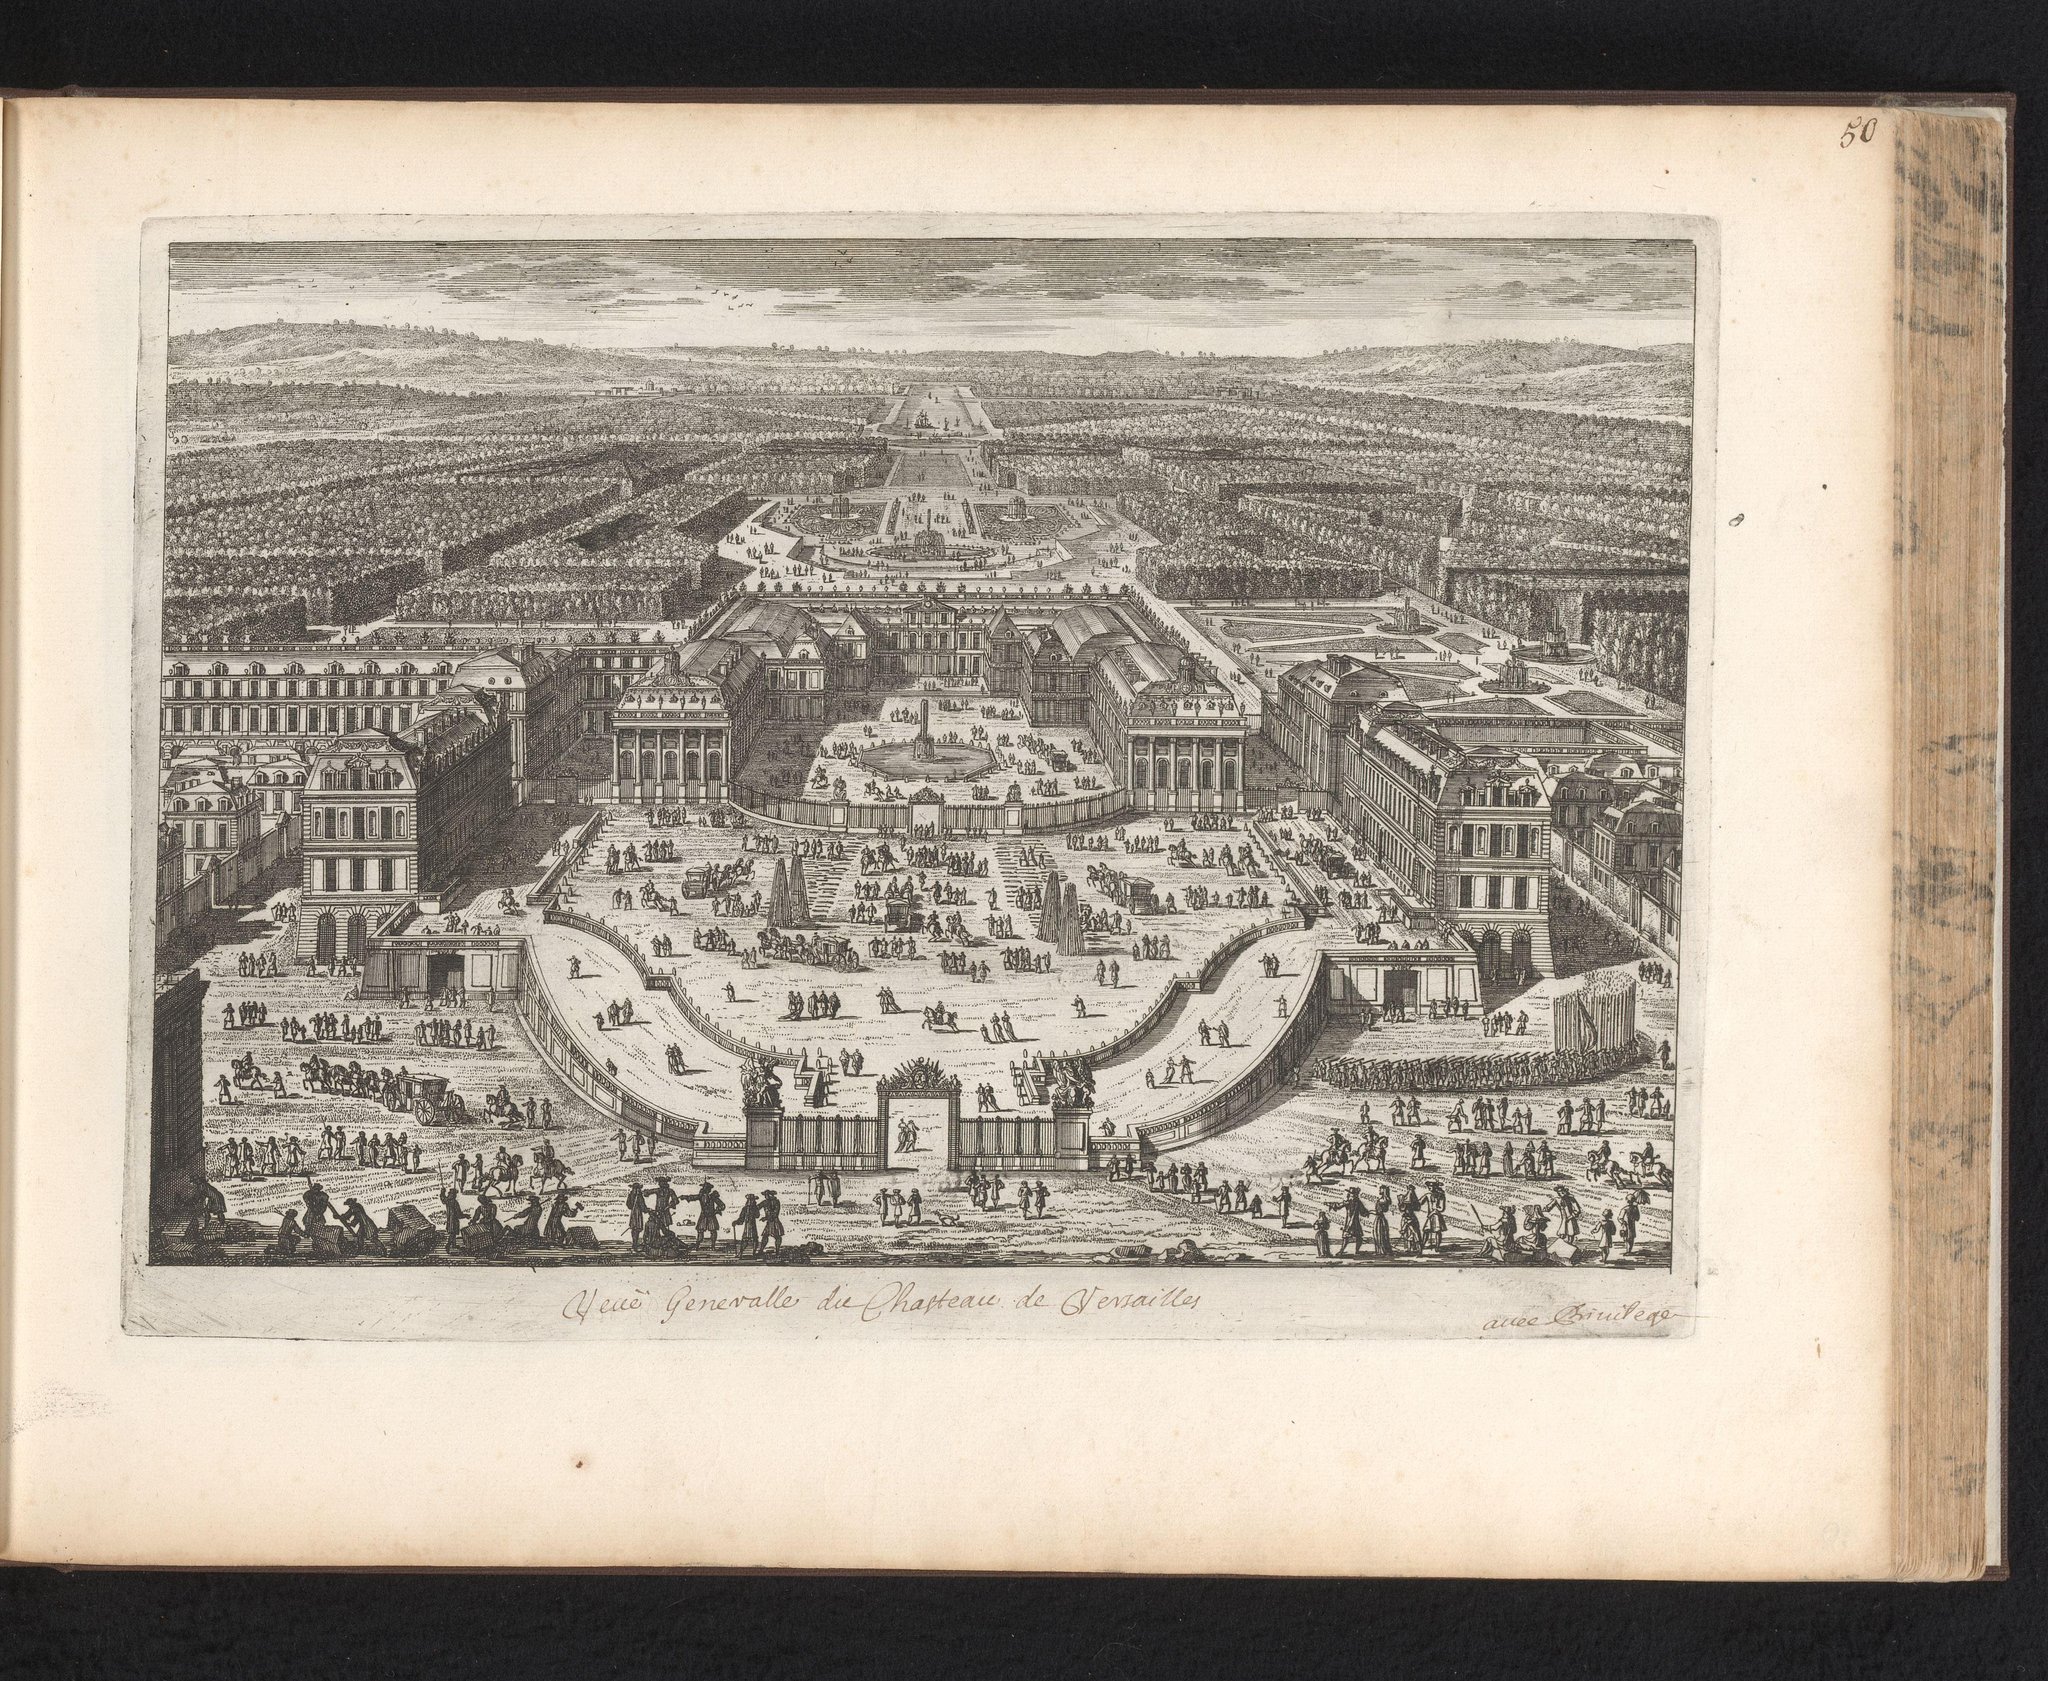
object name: album leaf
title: Veuë Generalle du Chasteau de Versailles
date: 1648-1691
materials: paper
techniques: etching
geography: paris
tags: landscape with tower or castle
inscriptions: collector's mark: Lugt 2228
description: Prenten met het signatuur 'Perelle' kunnen zowel door vader Gabriel als door zonen Nicolas en Adam gemaakt zijn. De uitgevers vader en zoon Nicolas Langlois worden allebei vermeld als N. Langlois op hetzelfde adres.